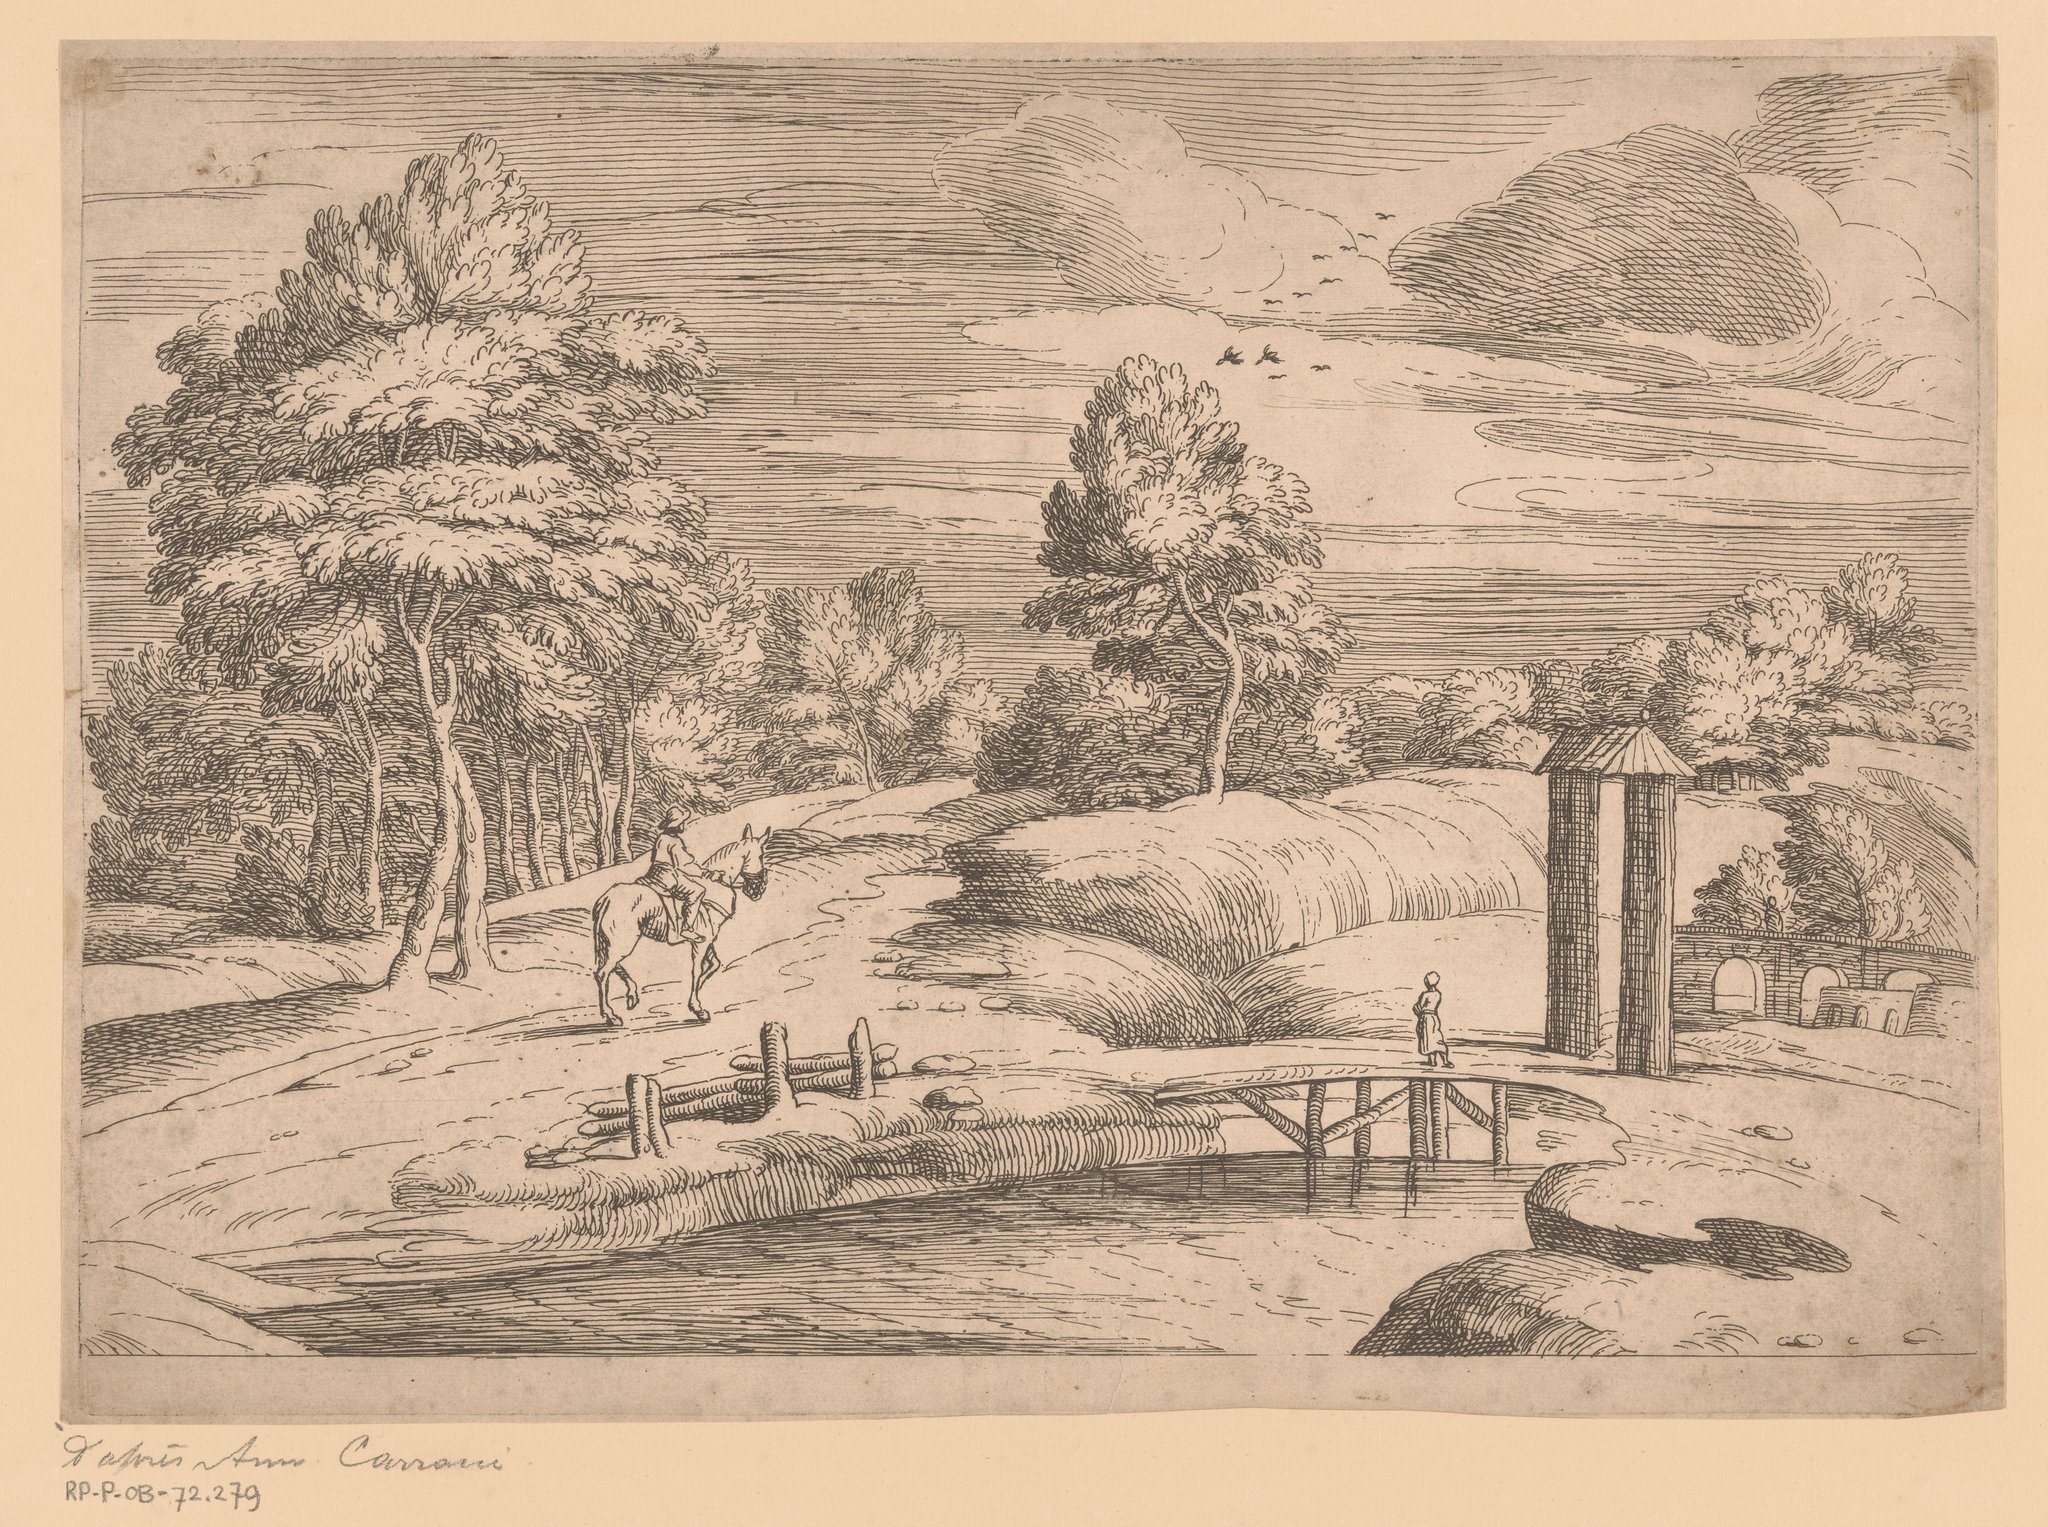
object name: print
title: Prenten naar tekeningen uit het kabinet Jabach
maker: jean pesne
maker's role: print maker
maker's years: 1623-1700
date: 1666-1695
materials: paper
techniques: etching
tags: water course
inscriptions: collector's mark: Lugt 240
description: Prent maakt deel uit van een serie van 283 prenten, ongenummerde staat.